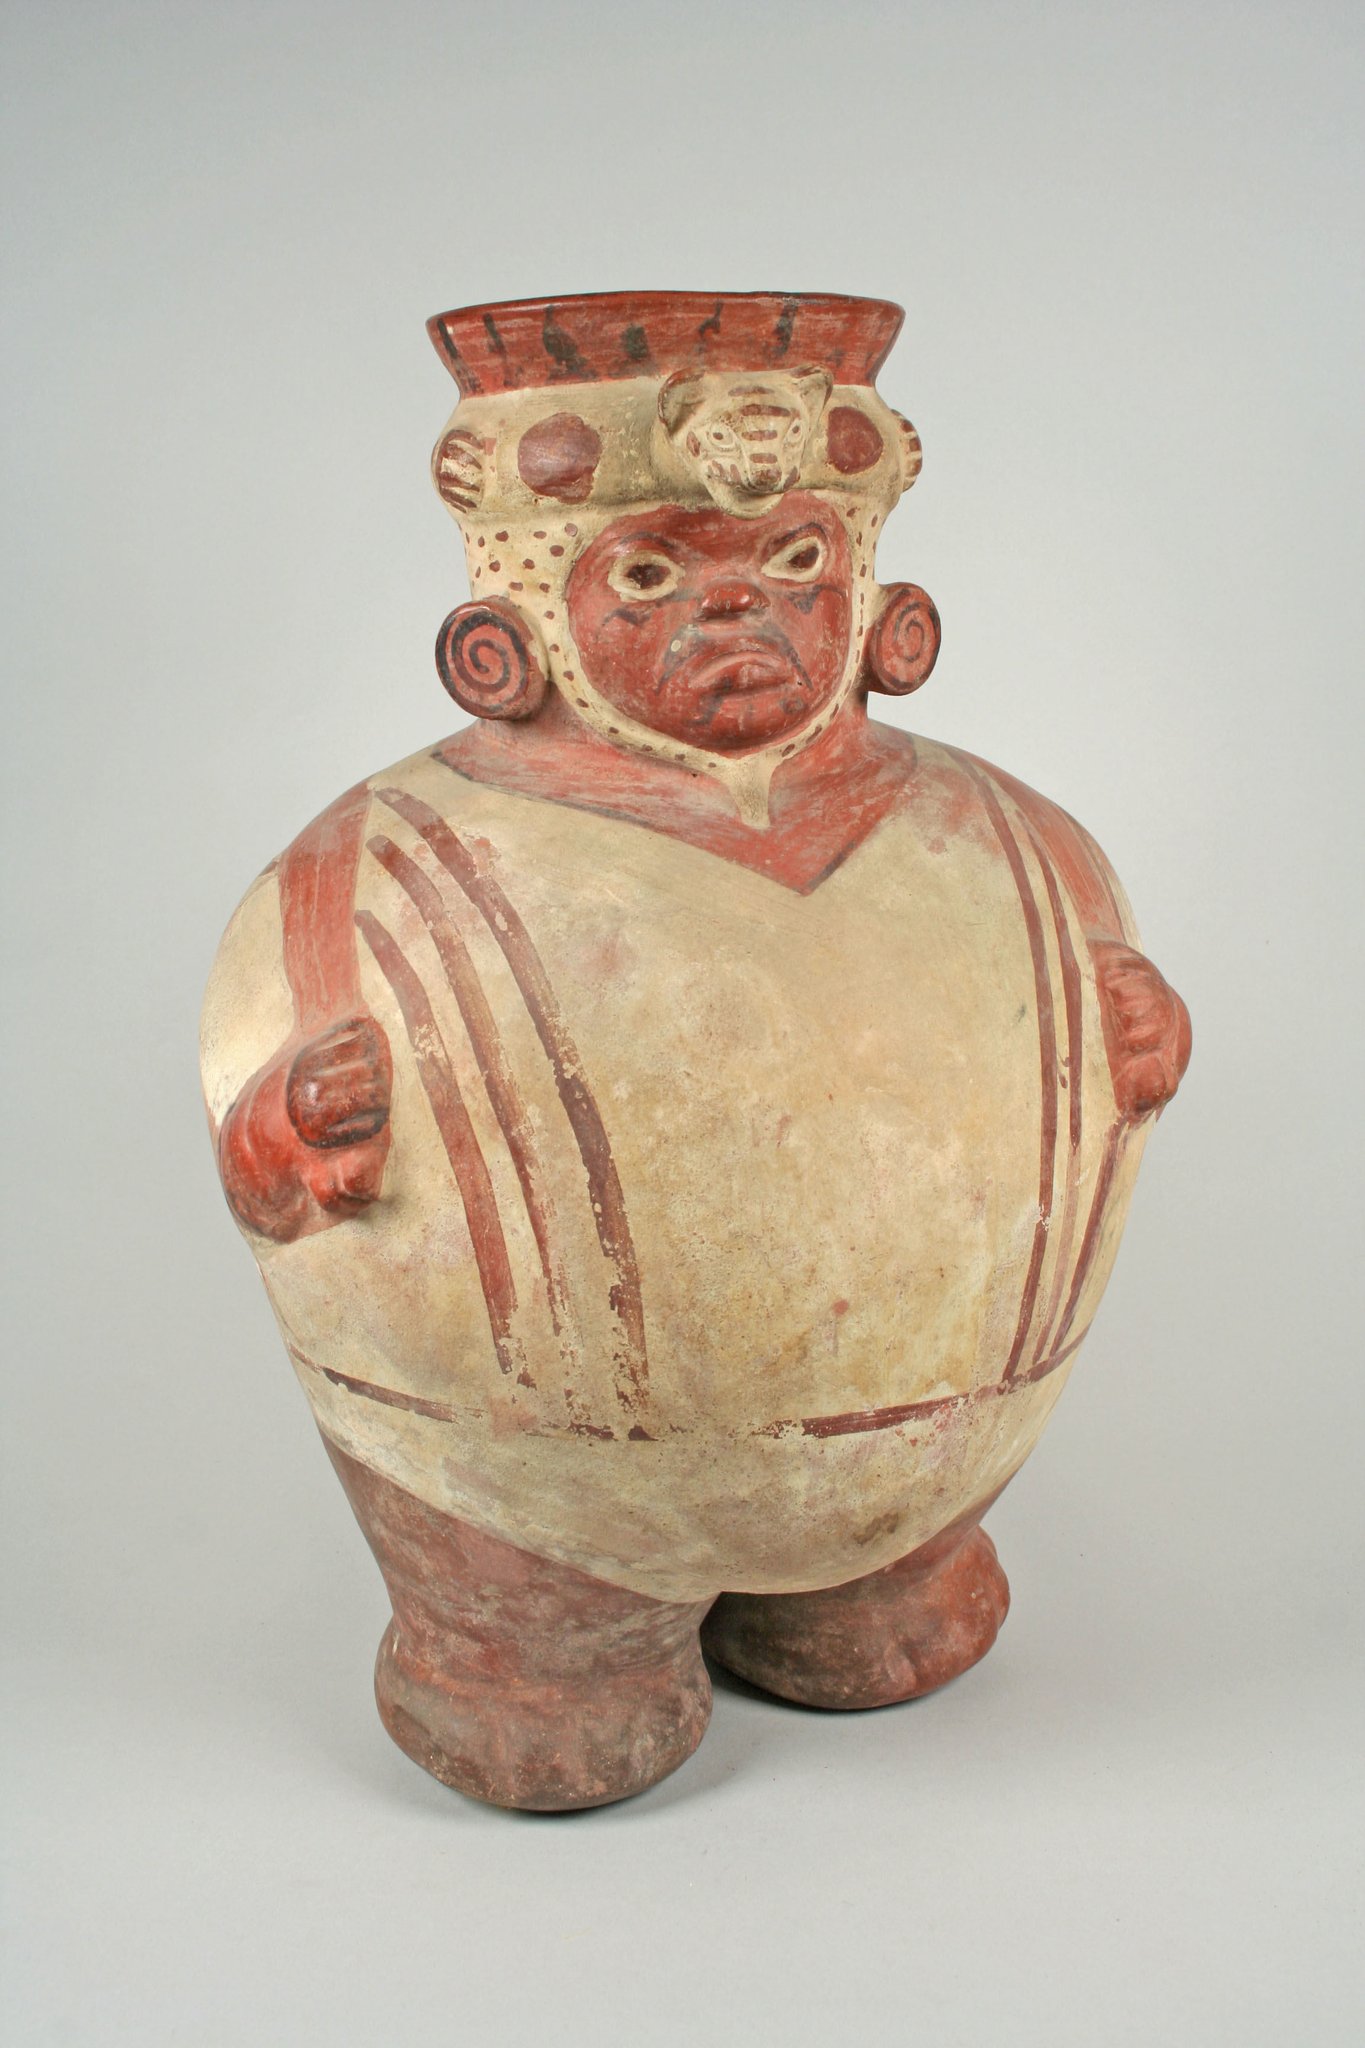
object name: bottle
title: Jar, Fat Figure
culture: moche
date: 201-600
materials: ceramic, pigment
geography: peru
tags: men